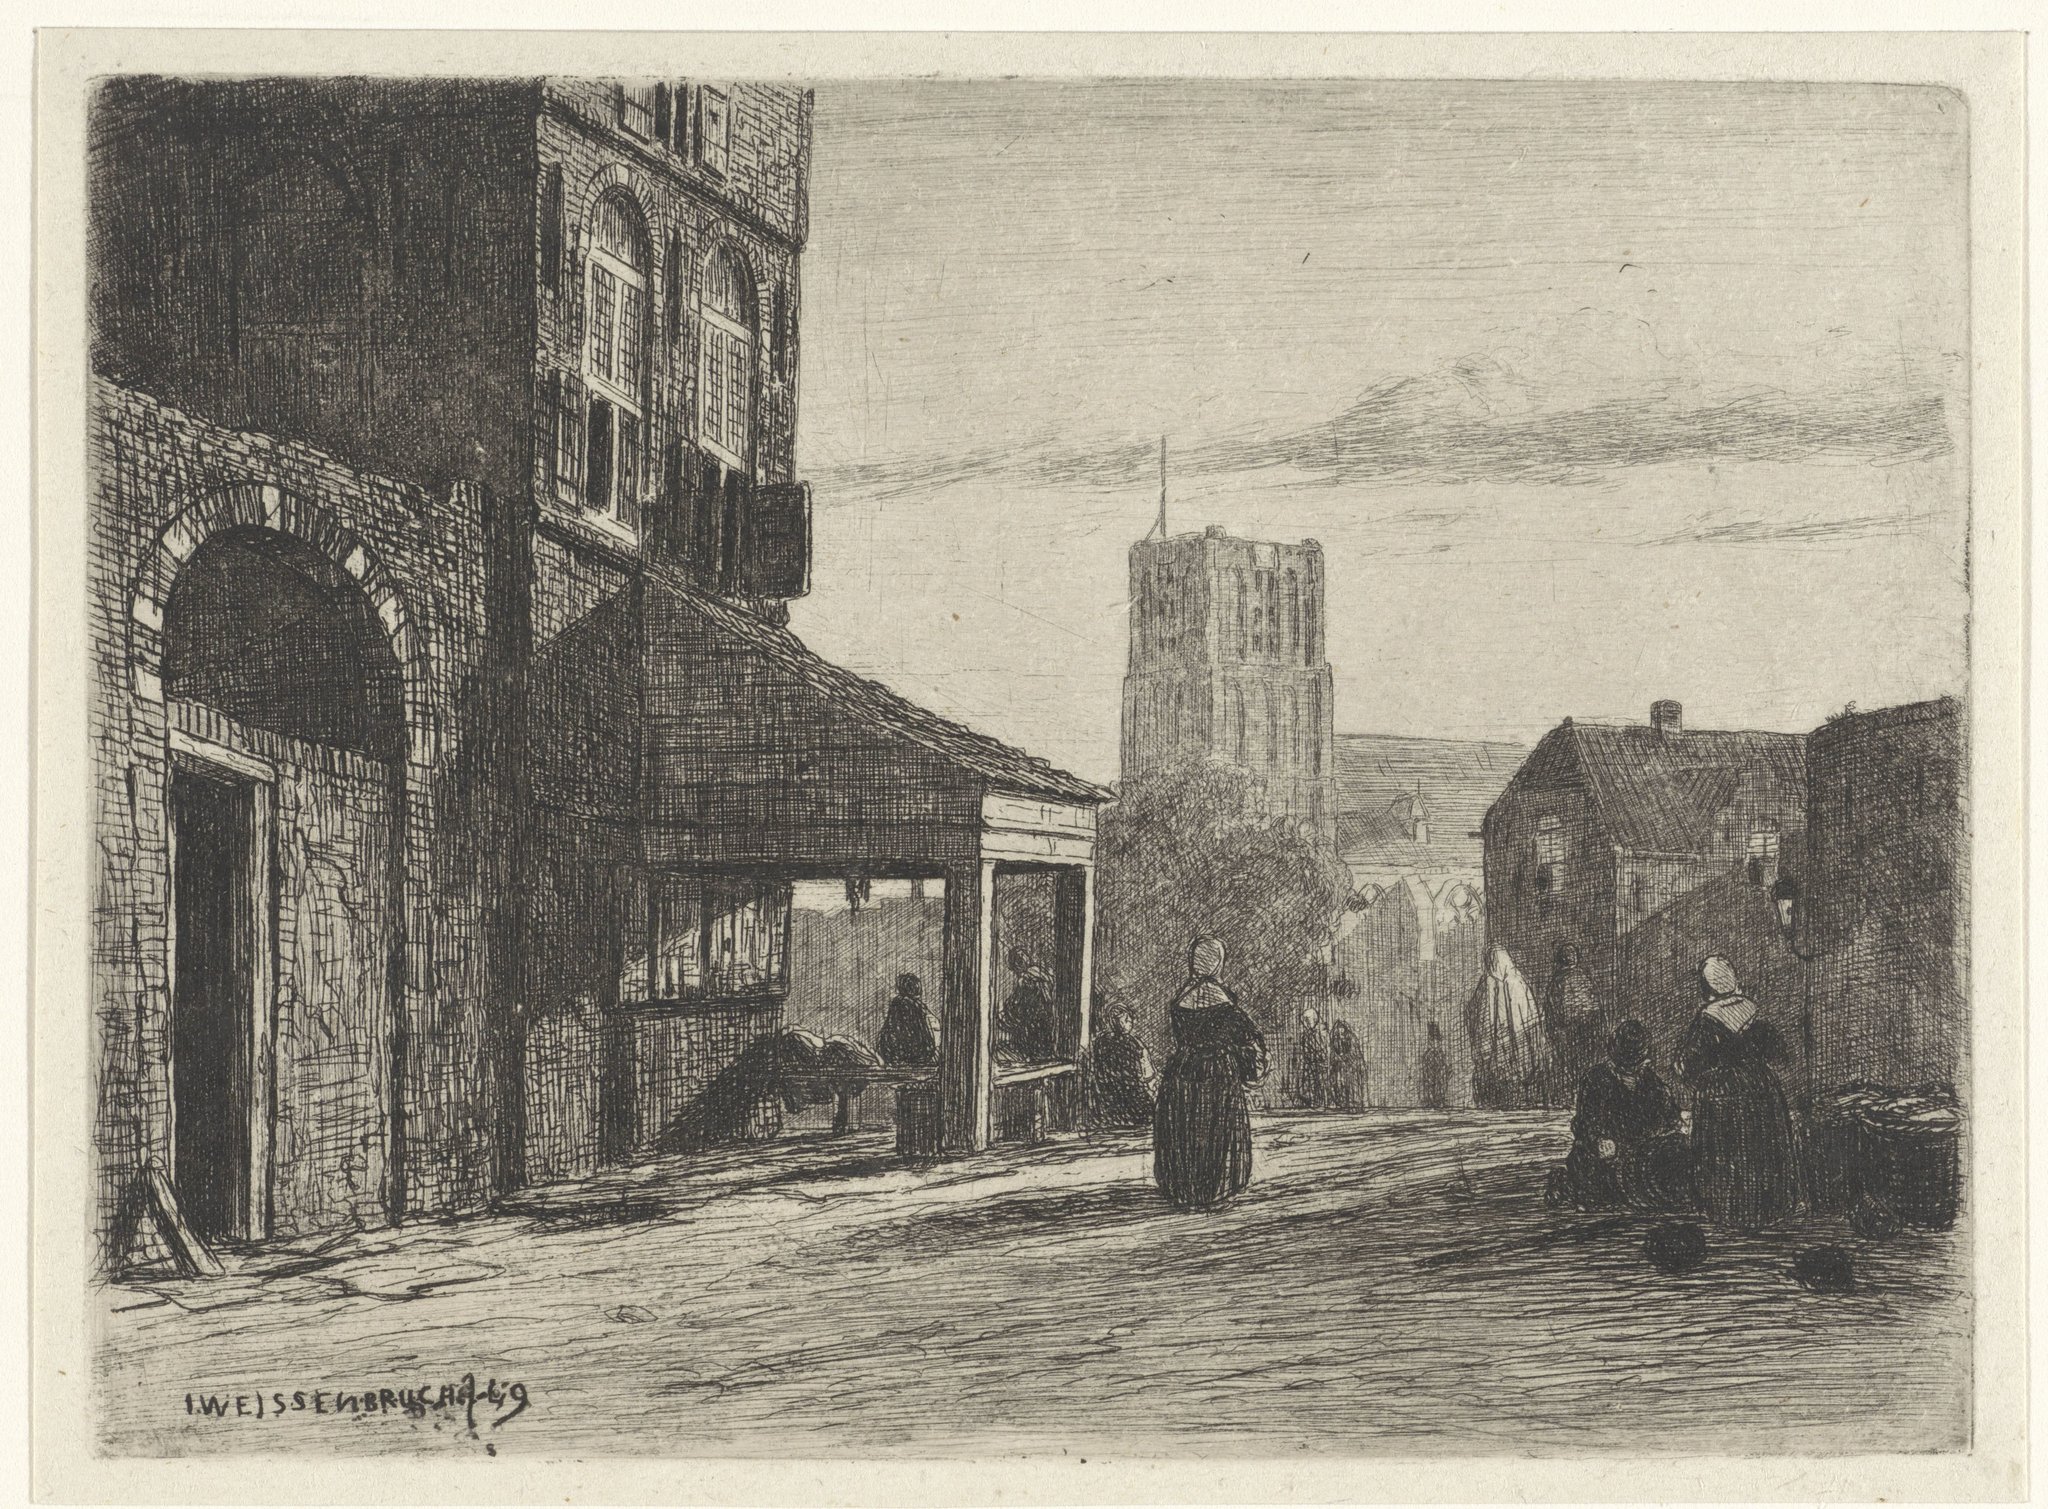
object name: print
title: Gezicht op de Sint-Martinuskerk te Woudrichem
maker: jan weissenbruch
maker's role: painter, print maker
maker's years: 1822-1880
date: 1849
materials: paper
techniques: etching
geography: the hague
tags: urban housing, adult woman, adult man, container made of plant material other than wood: basket, church (exterior), parts of church exterior and annexes, village square, place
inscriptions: collector's mark: Lugt 2228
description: Aan een dorpsplein staan enkele huizen. Rechts bevinden zich enkele figuren met manden. In de verte is de Sint-Martinuskerk te zien.